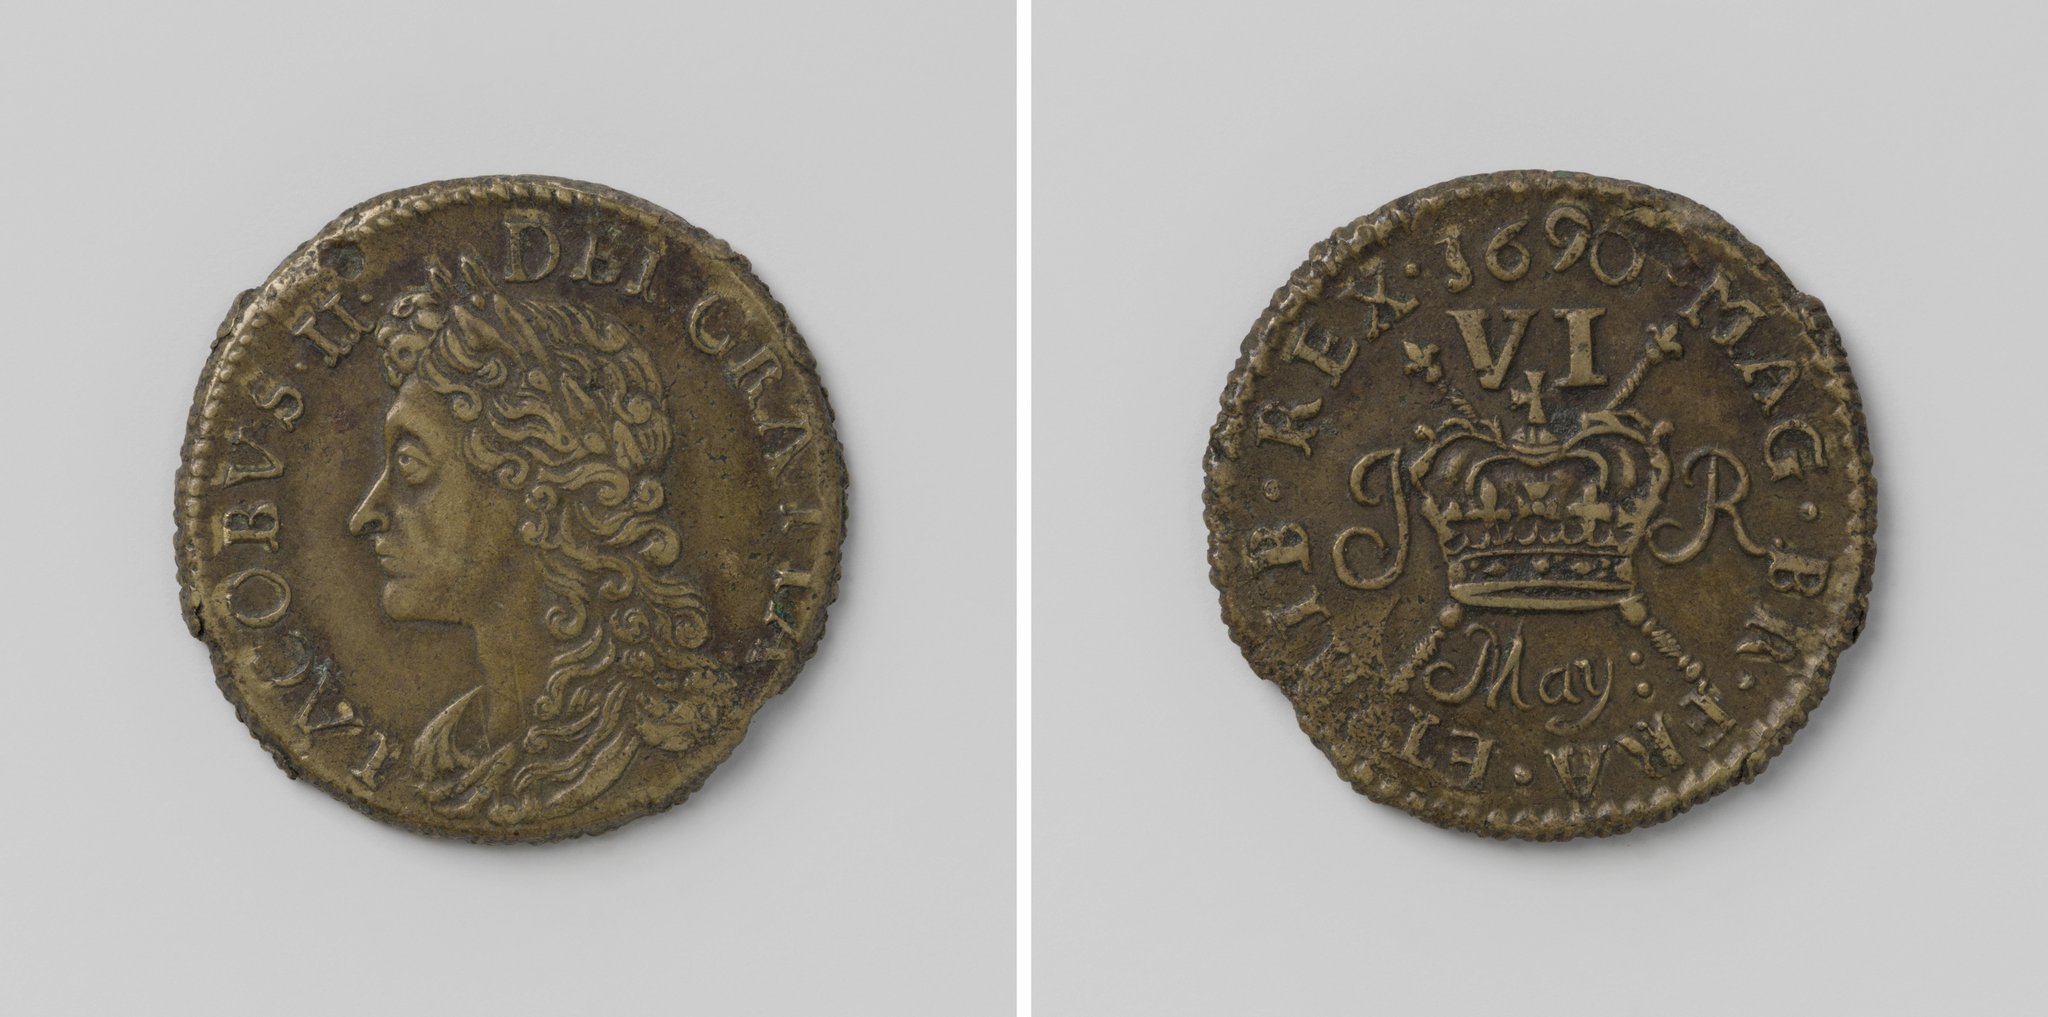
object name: siege coin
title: Zes pence, noodmunt van Jacobus II, koning van Engeland, uit mei 1690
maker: Anonymous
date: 1605-1690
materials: copper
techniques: striking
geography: ireland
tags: jacobus ii (koning van engeland en schotland)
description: Voorzijde: borststuk man met lauwerkrans binnen omschrift. Keerzijde: kroon, waardoor twee gekruiste scepters steken tussen monogram van letters J en R; boven kroon Romeinse cijfer VI, onder kroon opschrift "May: " binnen omschrift